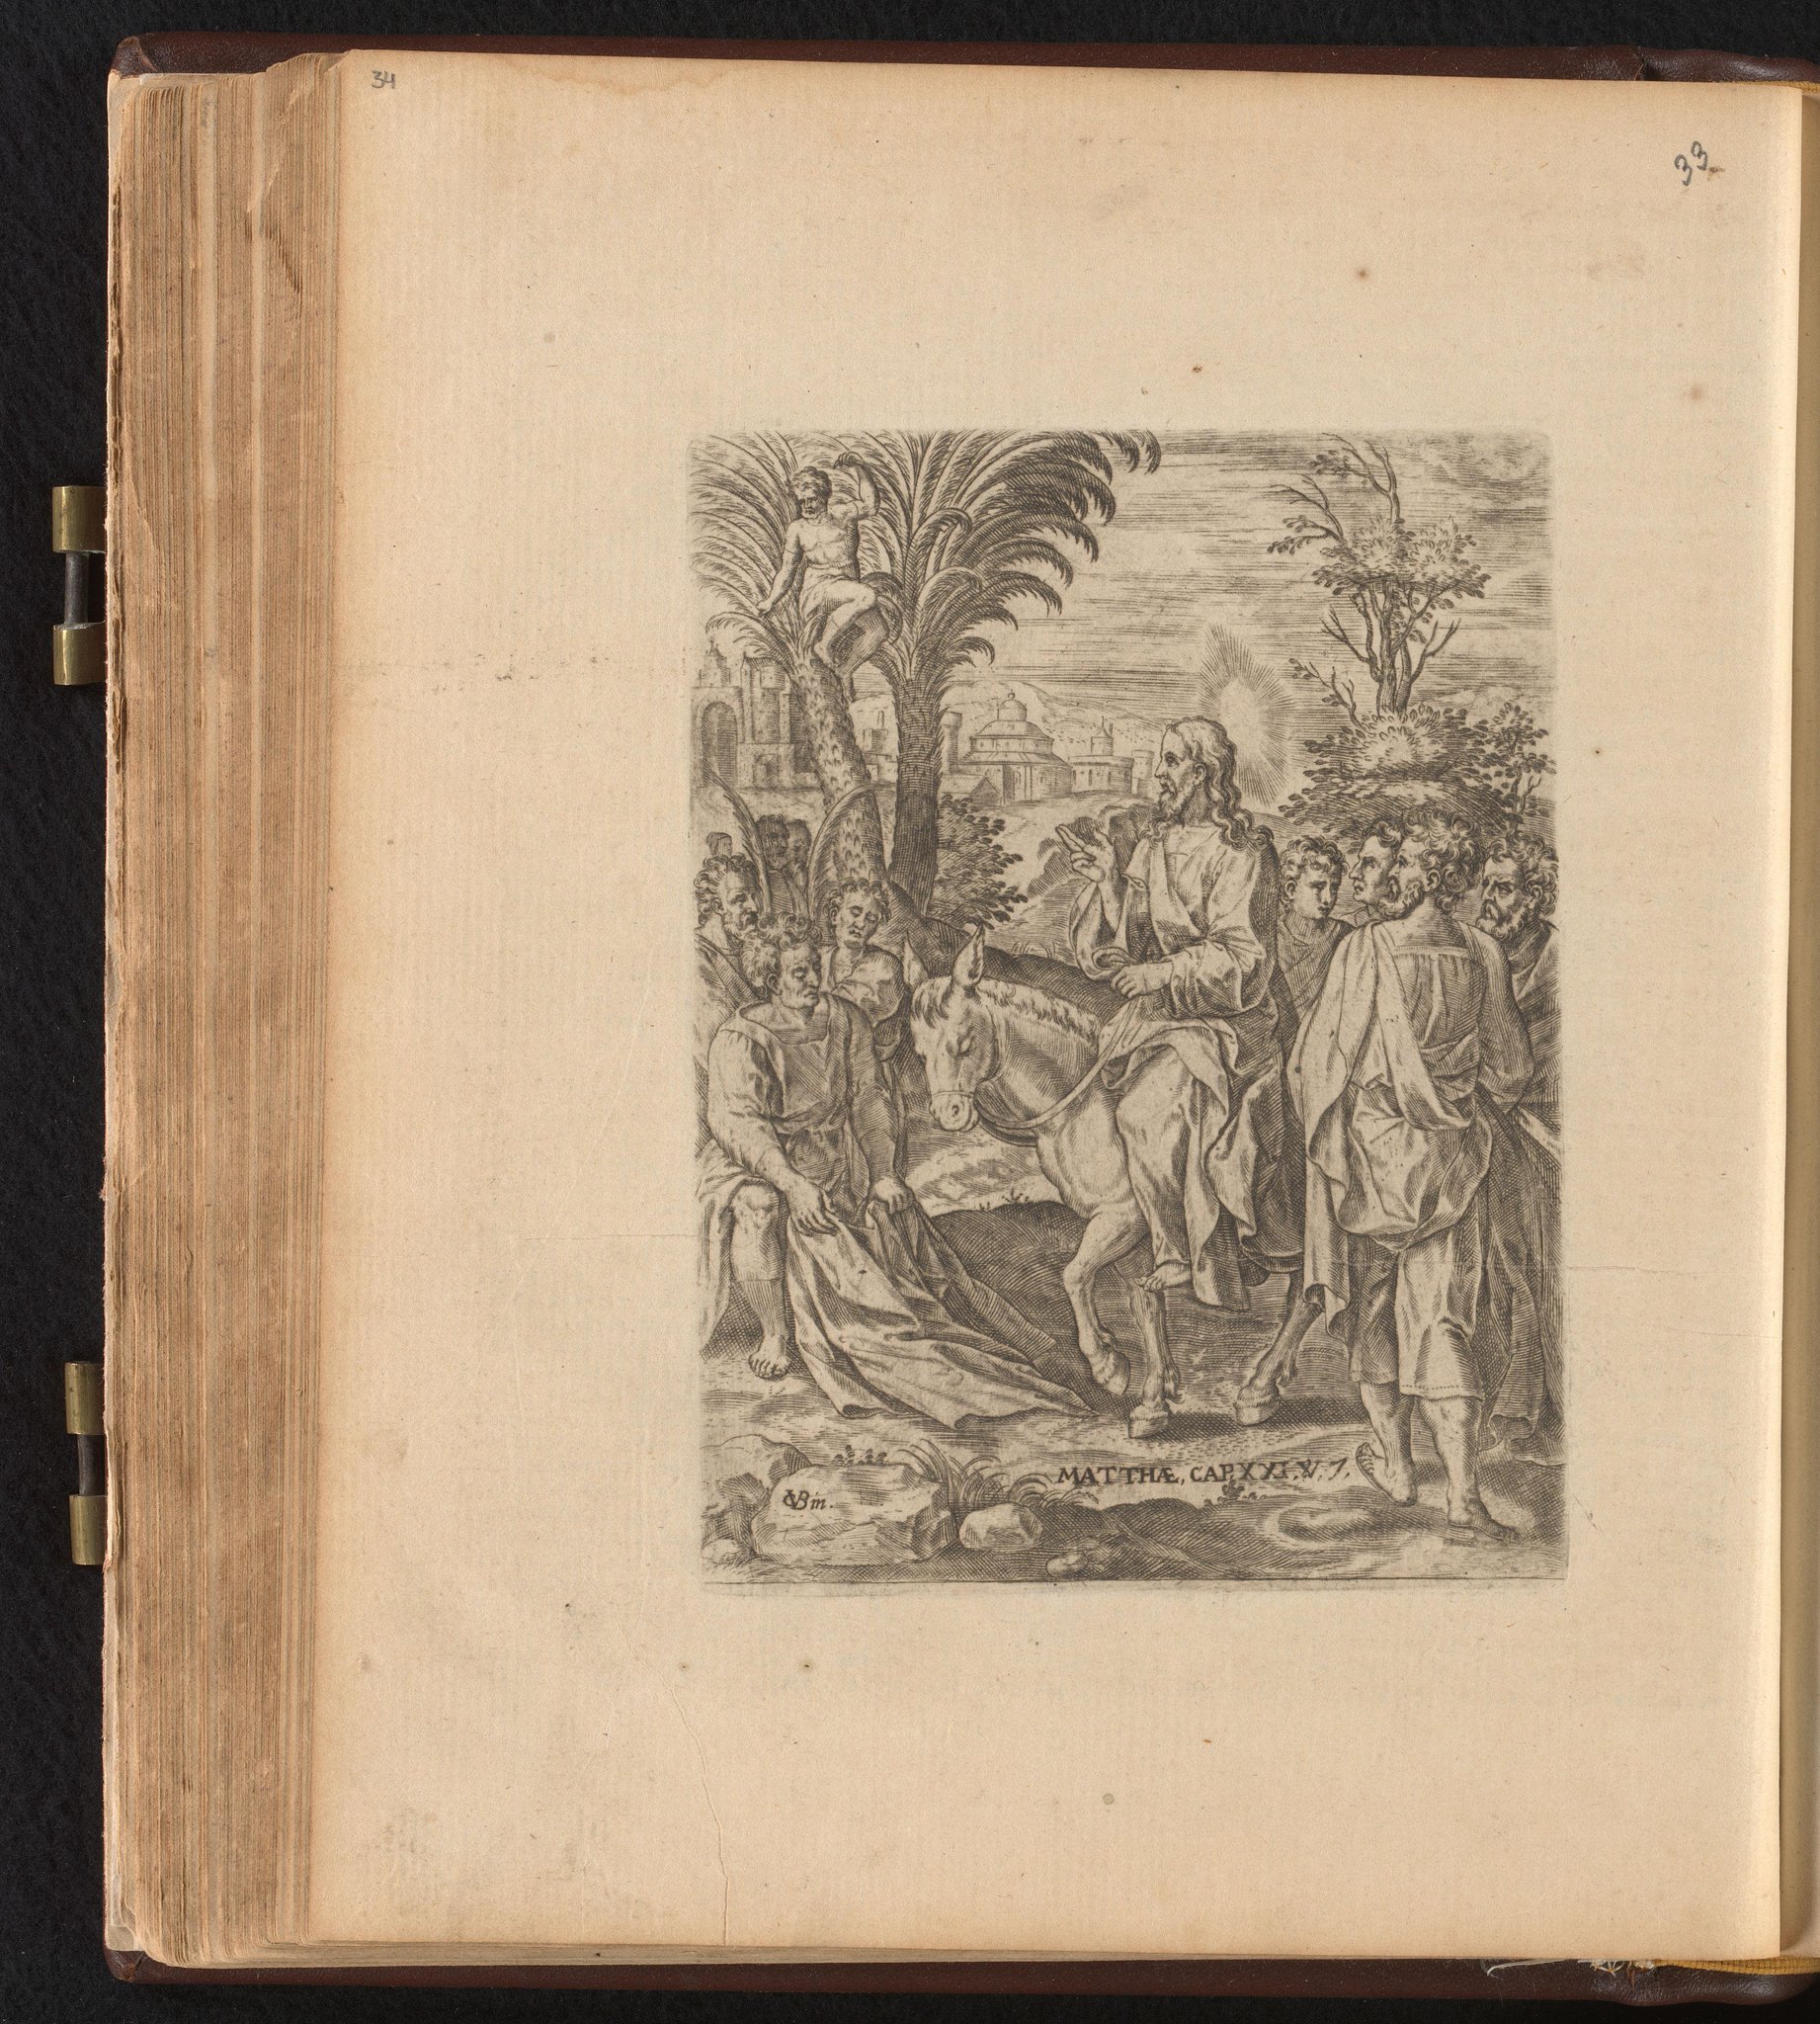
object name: album leaf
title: Intocht van Christus in Jeruzalem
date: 1594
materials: paper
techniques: engraving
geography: antwerp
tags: entry into jerusalem: people spreading their clothes before christ on the ass, and waving palm branches (matthew 21:1-11, 21:14-16; mark 11:1-11; luke 19:28-40; john 12:12-19)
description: Prent maakt deel uit van een prentbijbel.